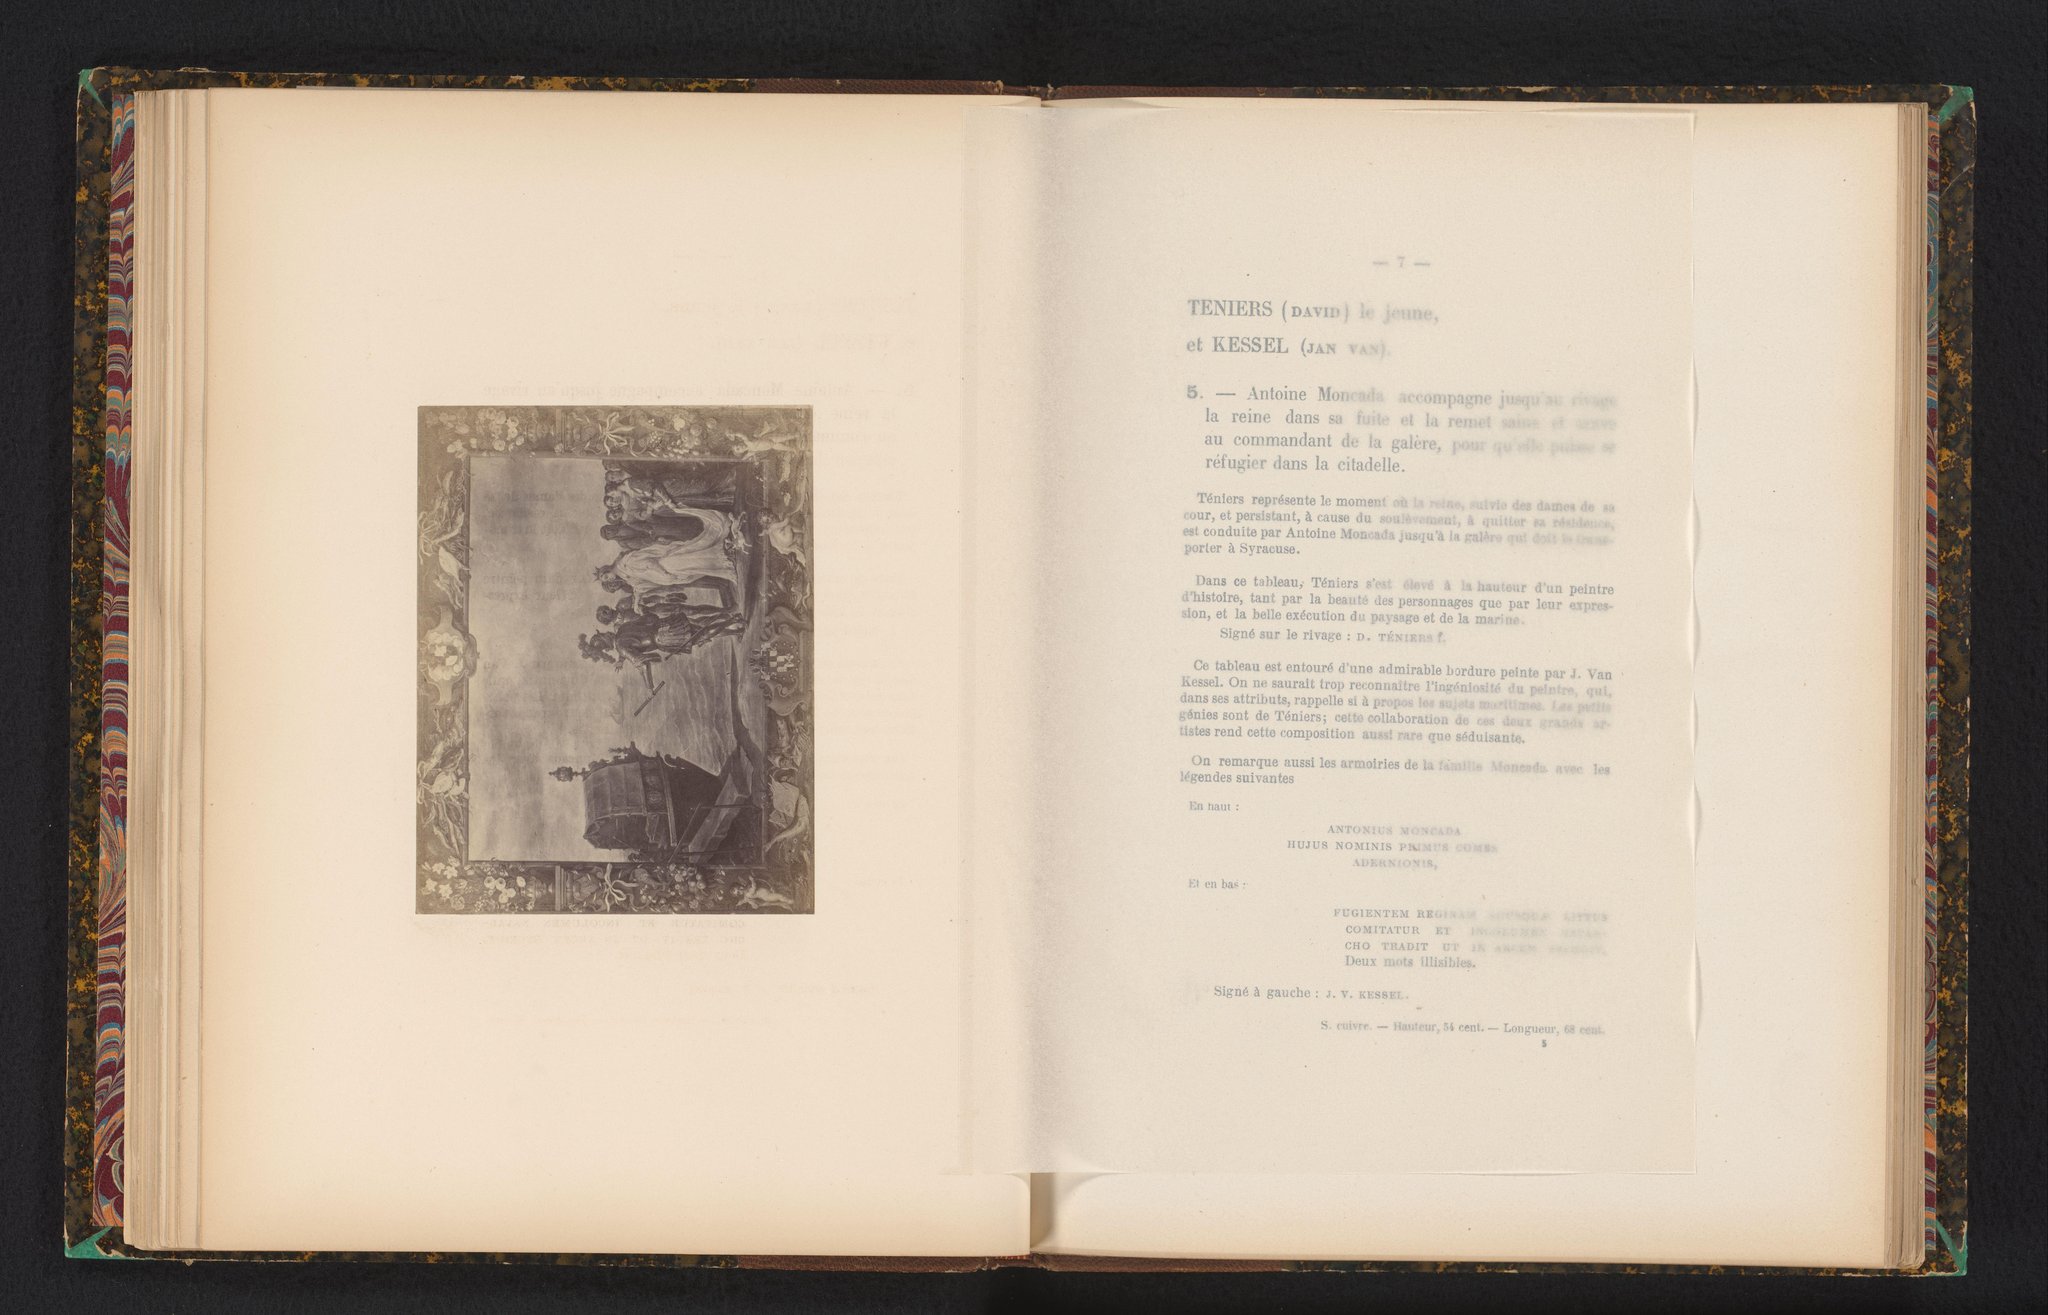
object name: page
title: Fotoreproductie van een schilderij van Antonius Moncada die koningin Blanca I begeleid naar het schip dat haar naar Syracuse zal brengen, door David Teniers en Jan van Kessel I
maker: Anonymous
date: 1865-1870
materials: photographic support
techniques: albumen print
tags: taking leave